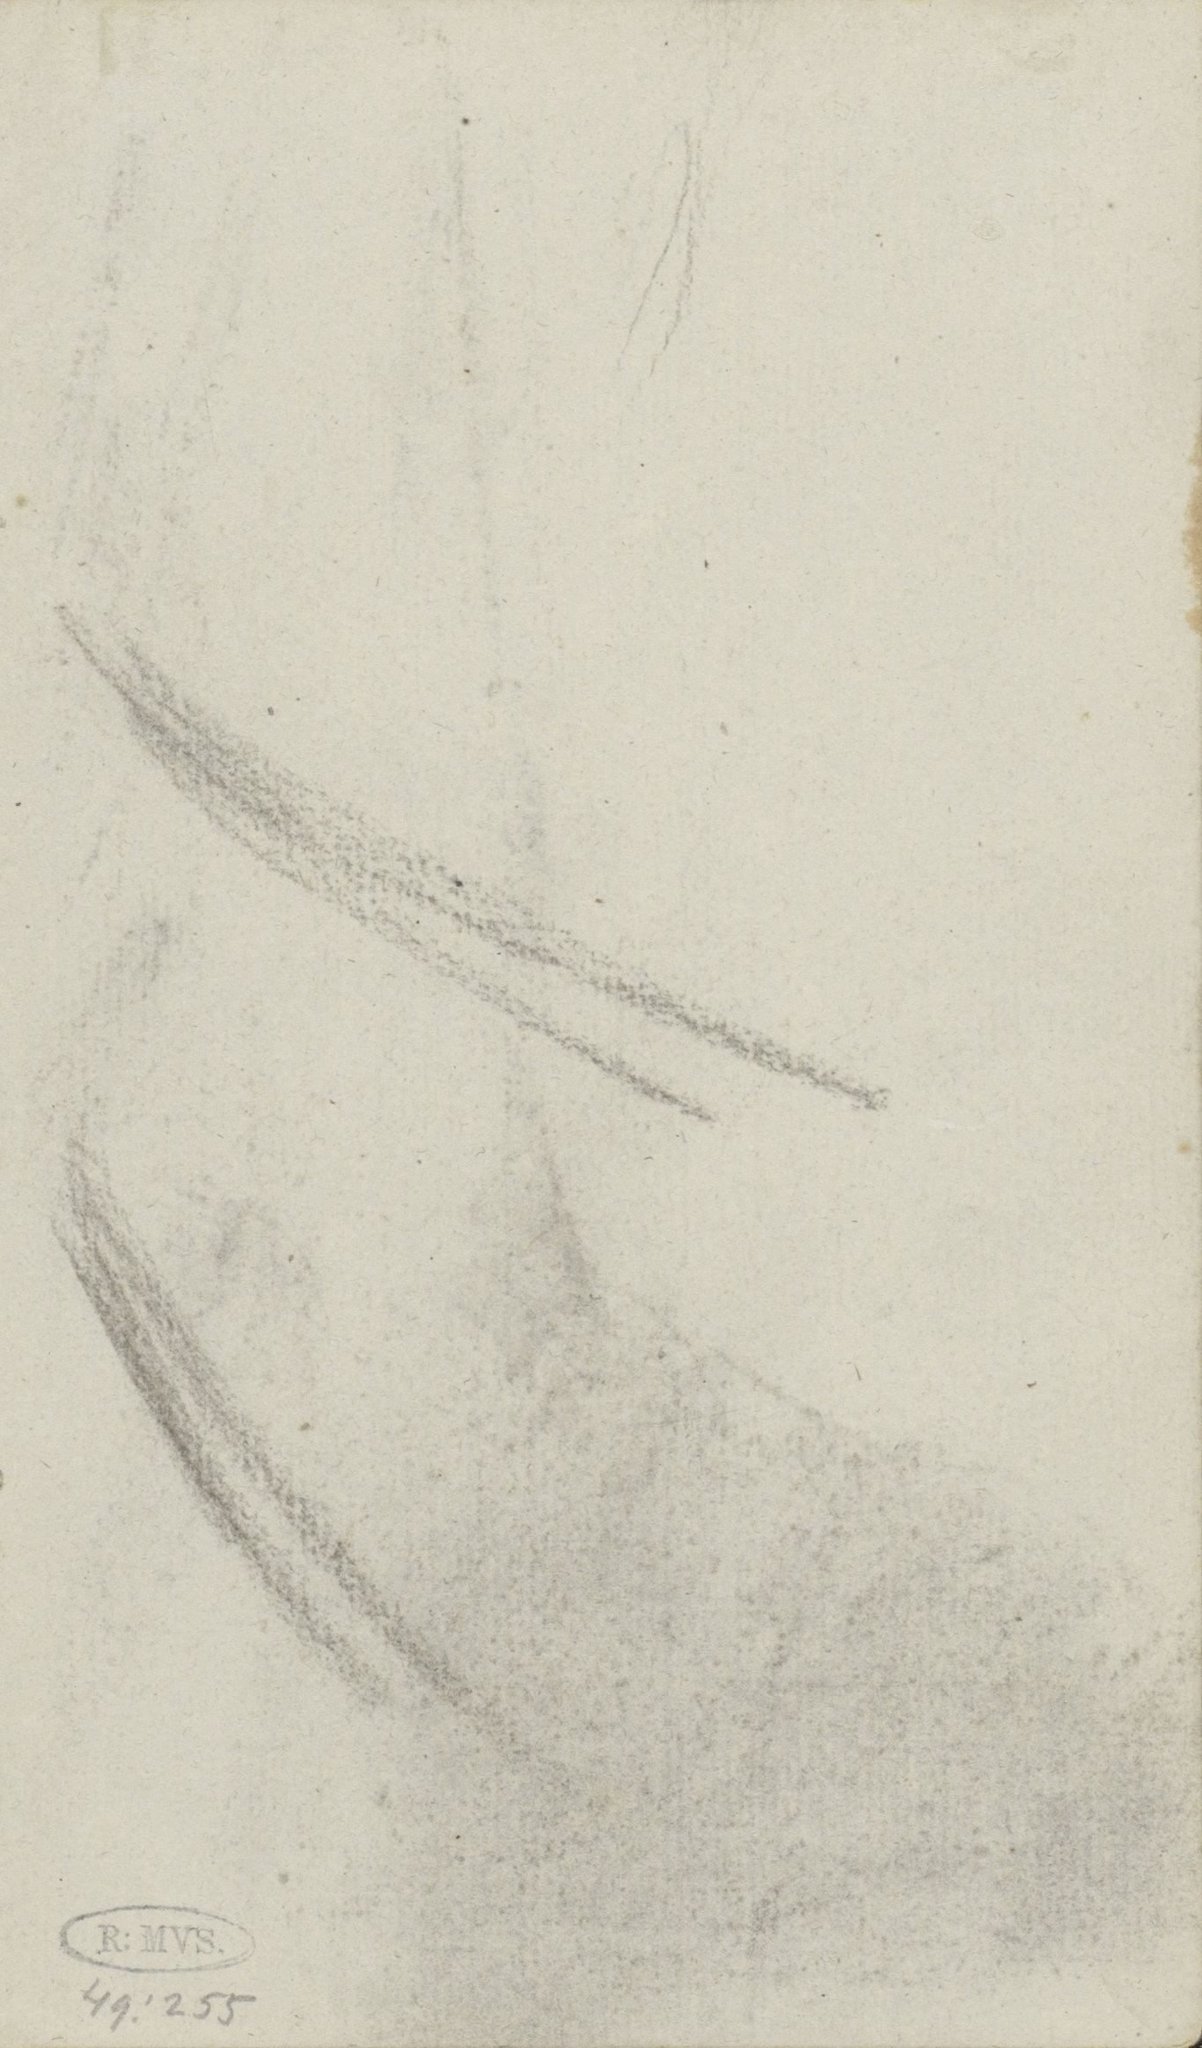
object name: drawing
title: Studie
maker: george hendrik breitner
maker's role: draughtsman, painter, print maker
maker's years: 1857-1923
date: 1882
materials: chalk, paper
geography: amsterdam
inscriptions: collector's mark: Lugt 2228